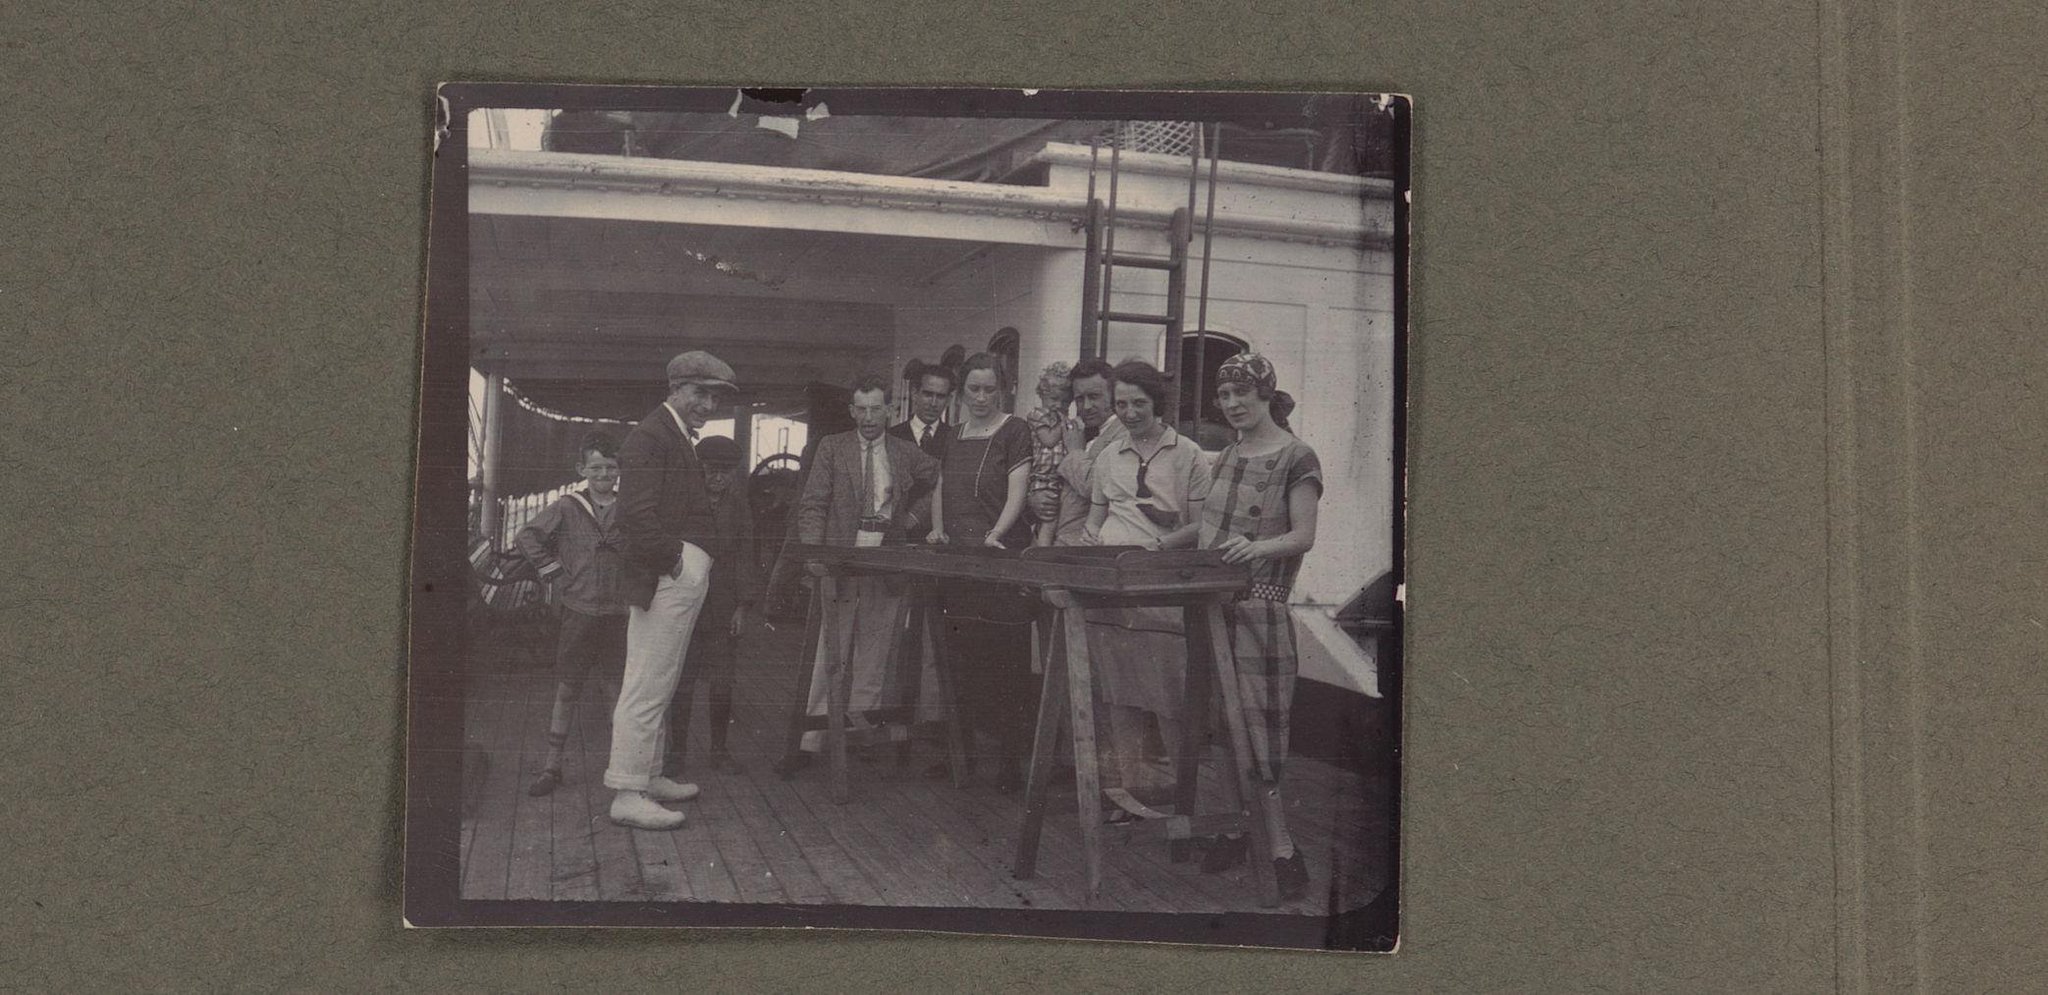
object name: photograph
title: Sjoelen aan dek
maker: Anonymous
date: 1925-1927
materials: photographic support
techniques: photography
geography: suriname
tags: jetten, familie, moengo, madeira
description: Sjoelen aan dek, tijdens bezoek aan Madeira. Foto op een bladzijde van een los albumblad. Onderdeel van het ensemble met foto's van de familie van ingenieur Jetten in de mijnbouwstad Moengo in Suriname.